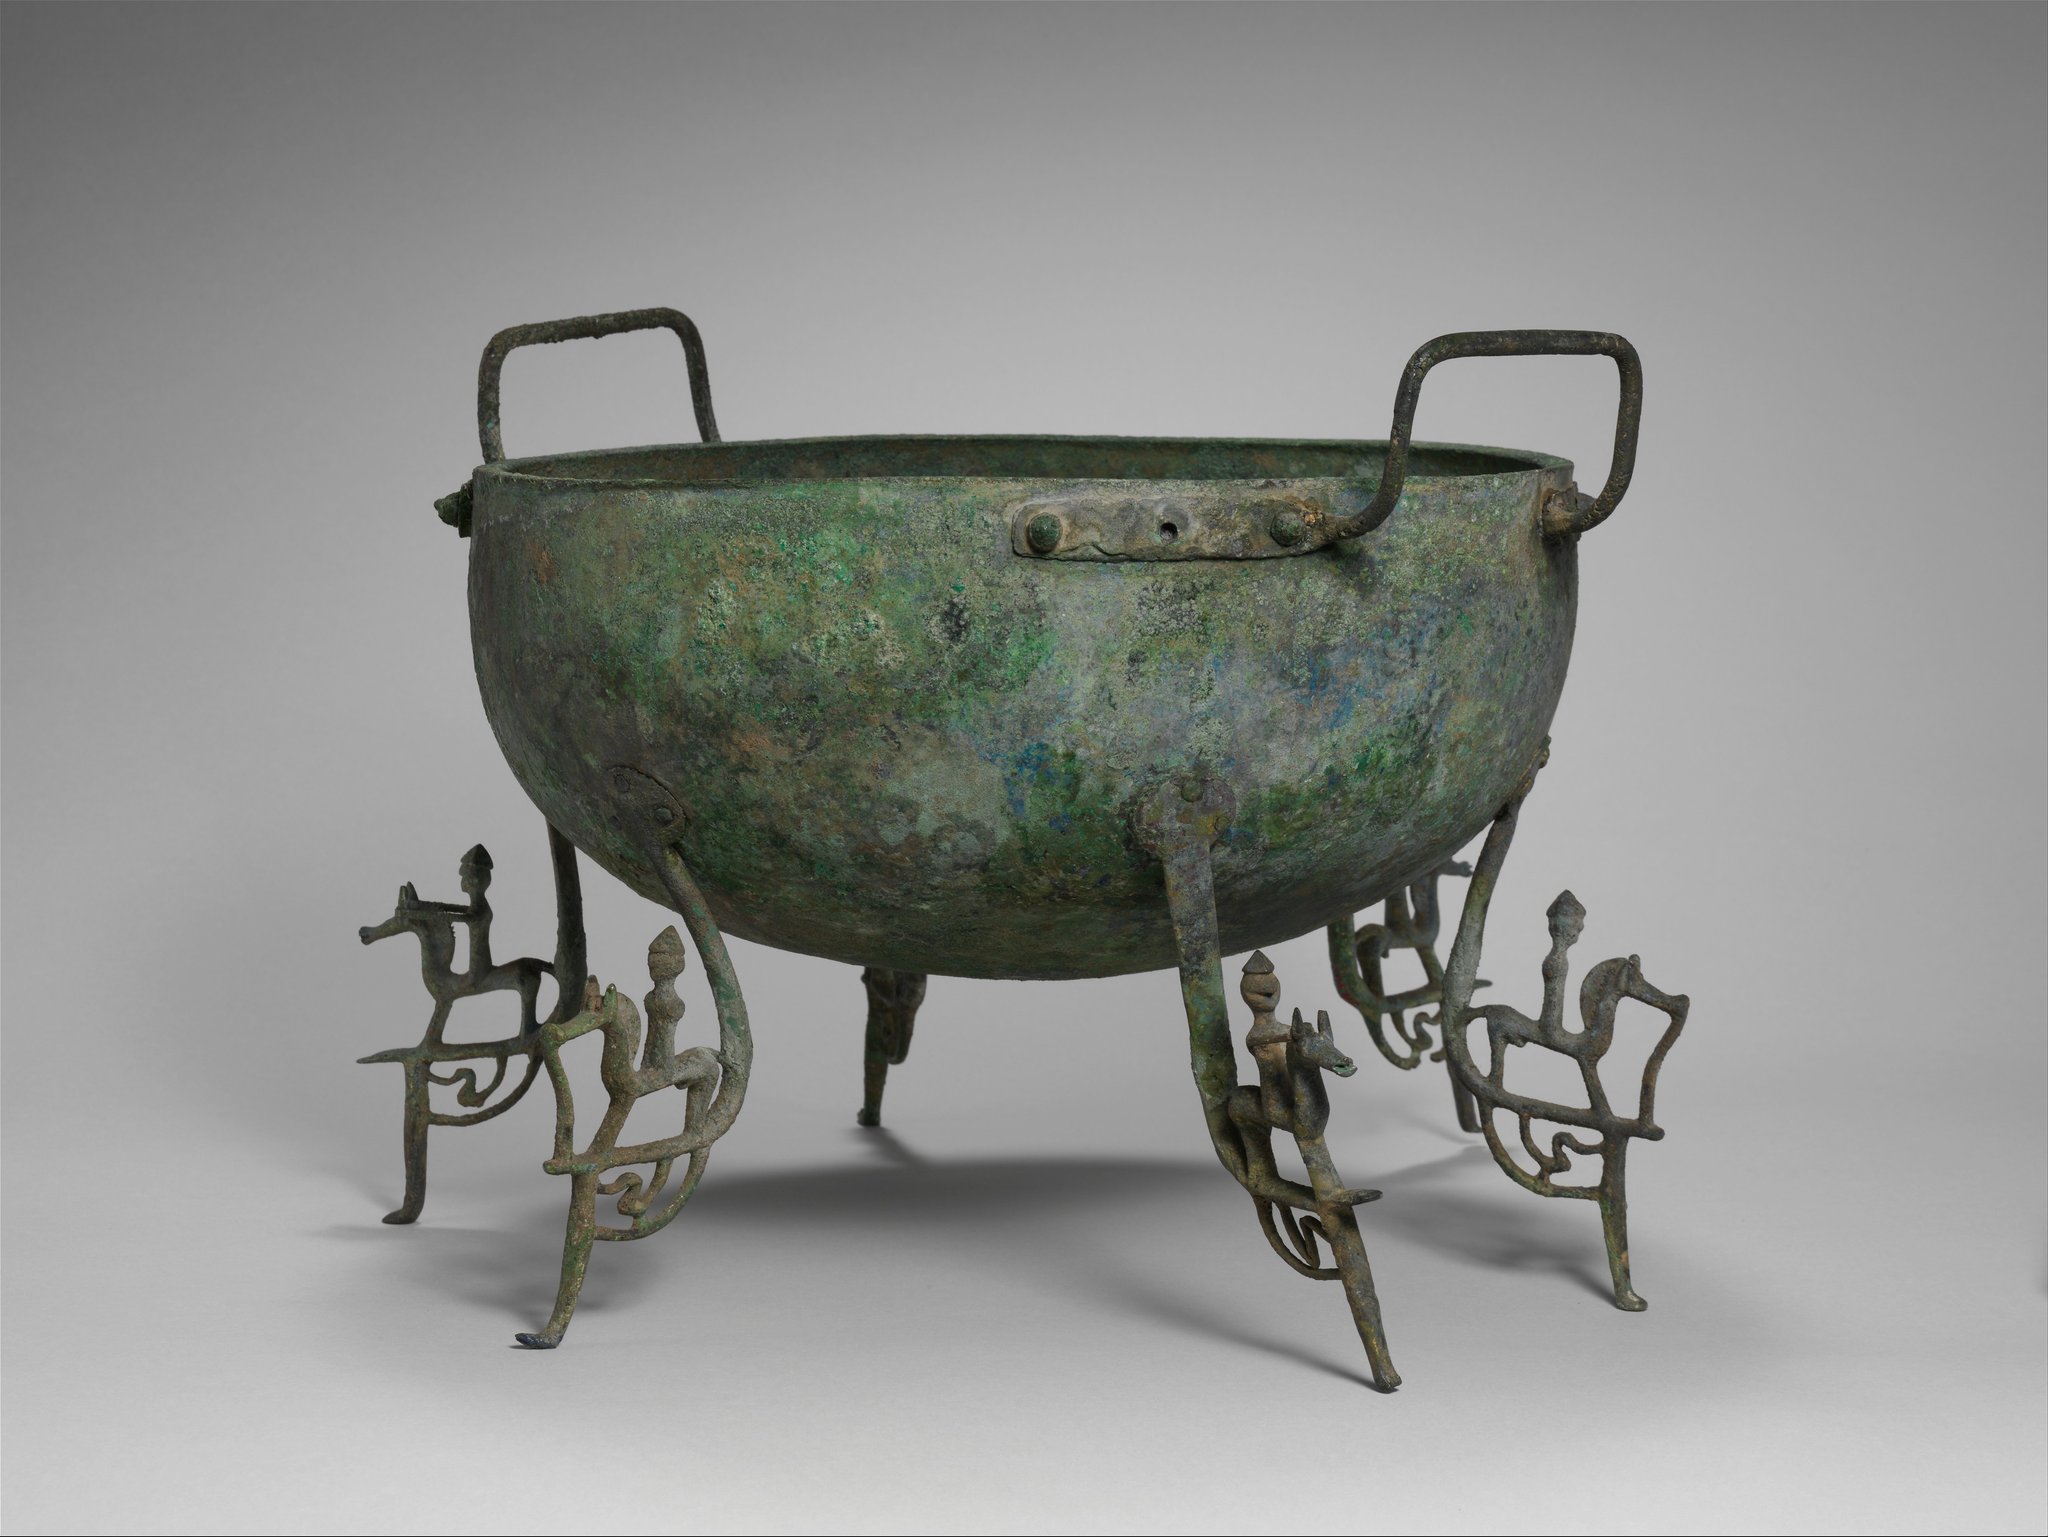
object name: basin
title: Bronze basin with six legs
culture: etruscan or late villanovan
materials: bronze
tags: horses